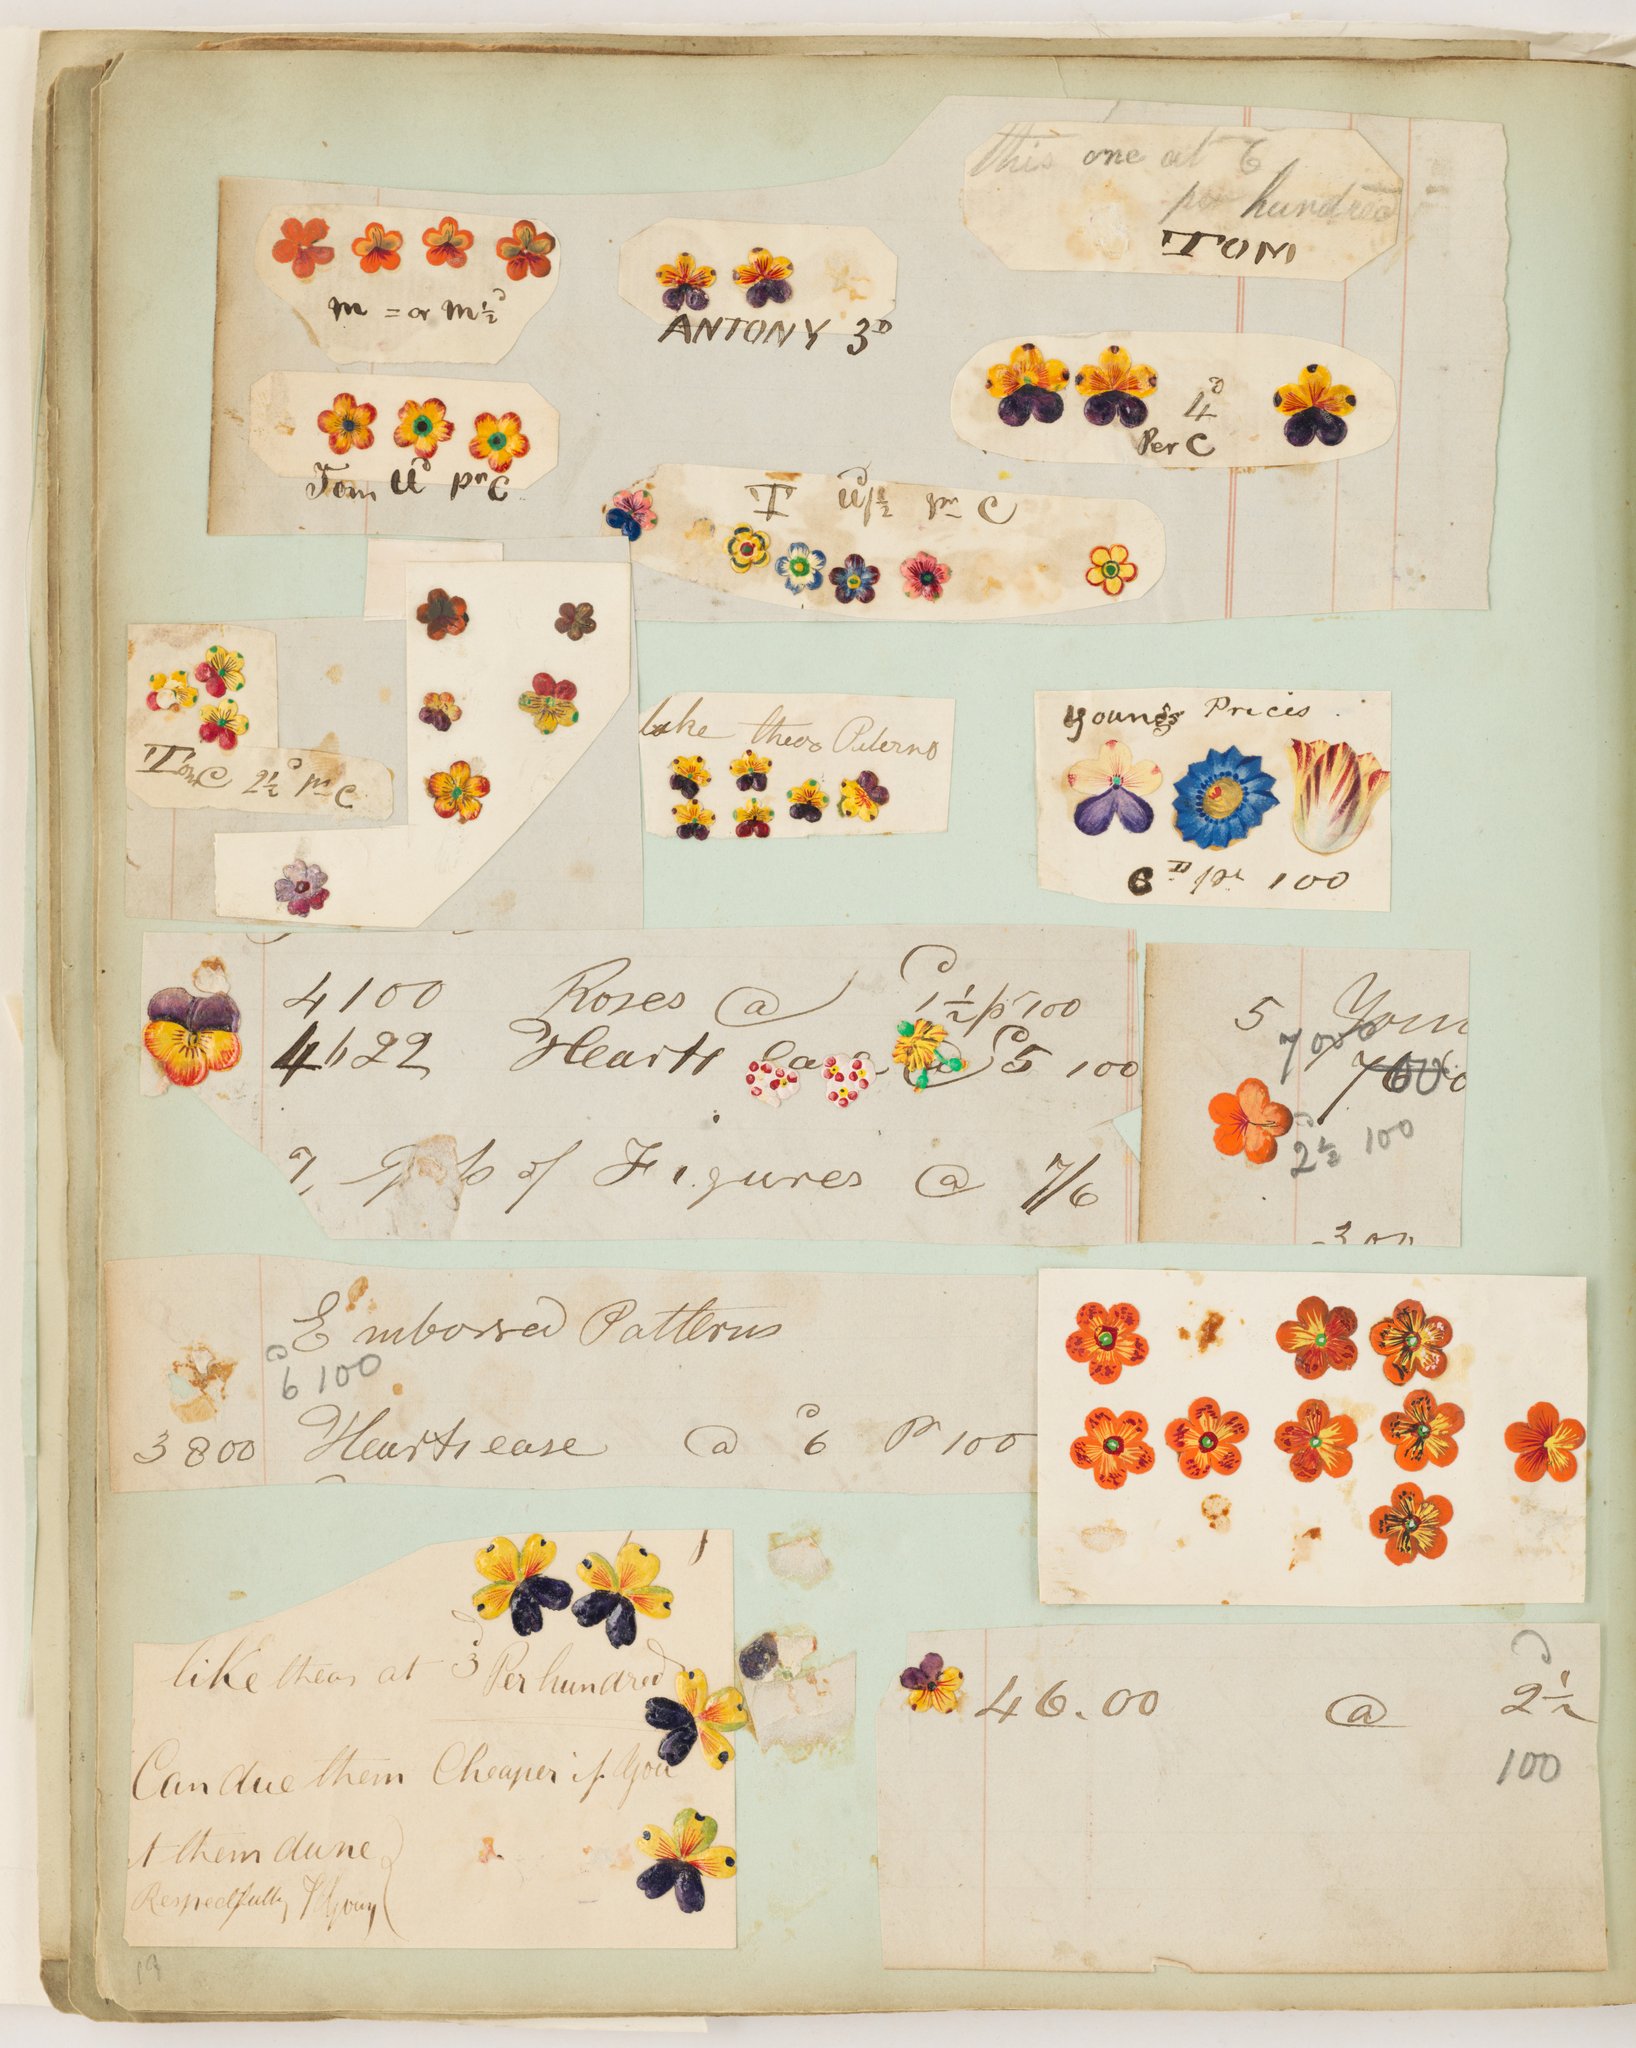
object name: scrapbook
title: Valentine makers' scrapbook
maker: anonymous, british, 19th century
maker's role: artist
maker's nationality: british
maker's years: 1800-1900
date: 1834-1866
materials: gilt, ink, paper, watercolor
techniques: cutting